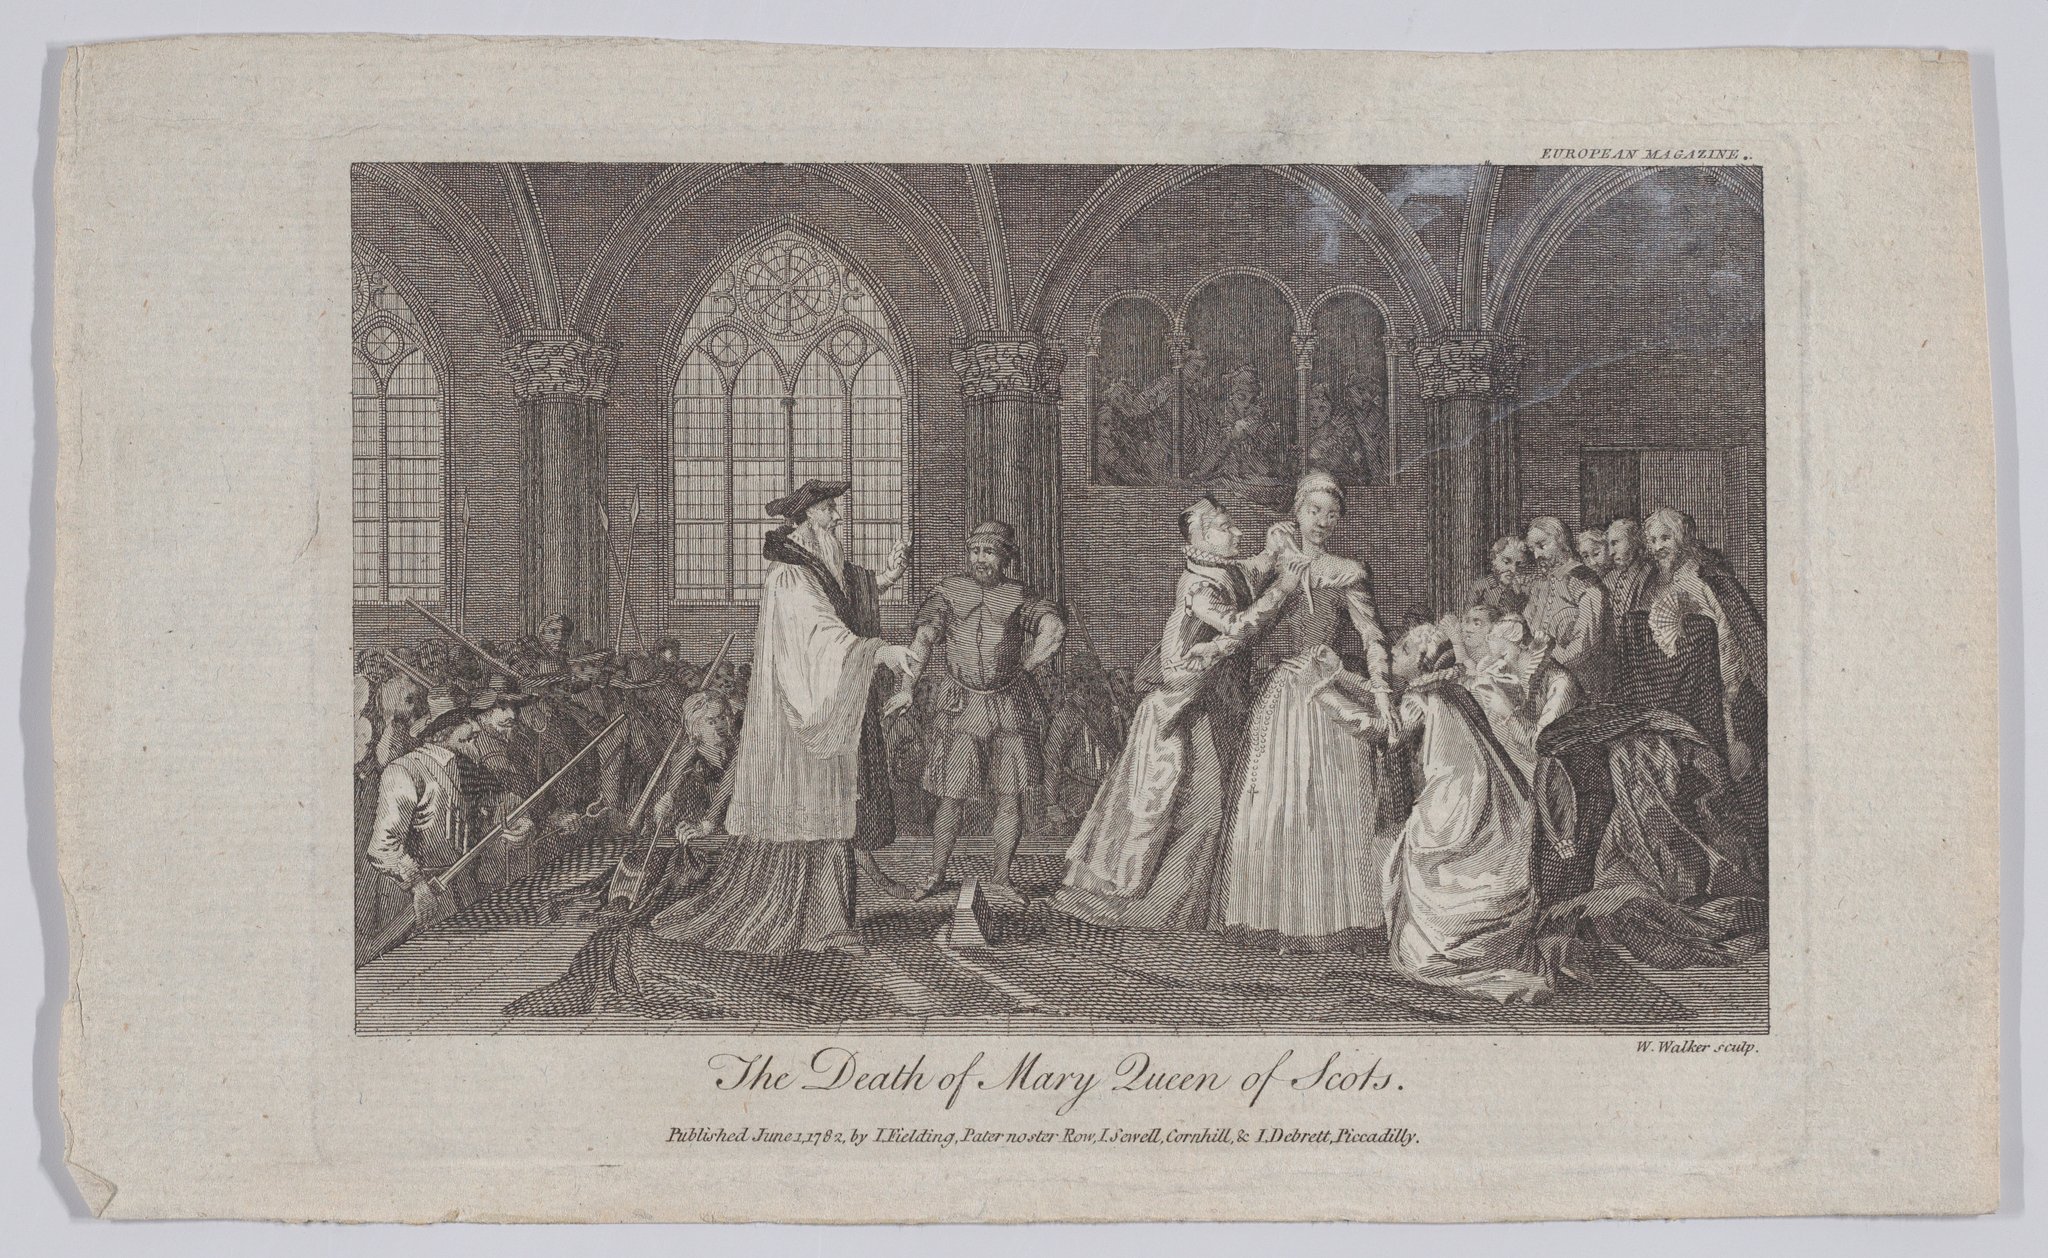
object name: print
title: The Death of Mary Queen of Scots (from "European Magazine and London Review," volume I)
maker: william walker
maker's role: artist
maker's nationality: british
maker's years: 1729-1793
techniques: etching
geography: england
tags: queens,men,women,execution,mary queen of scots